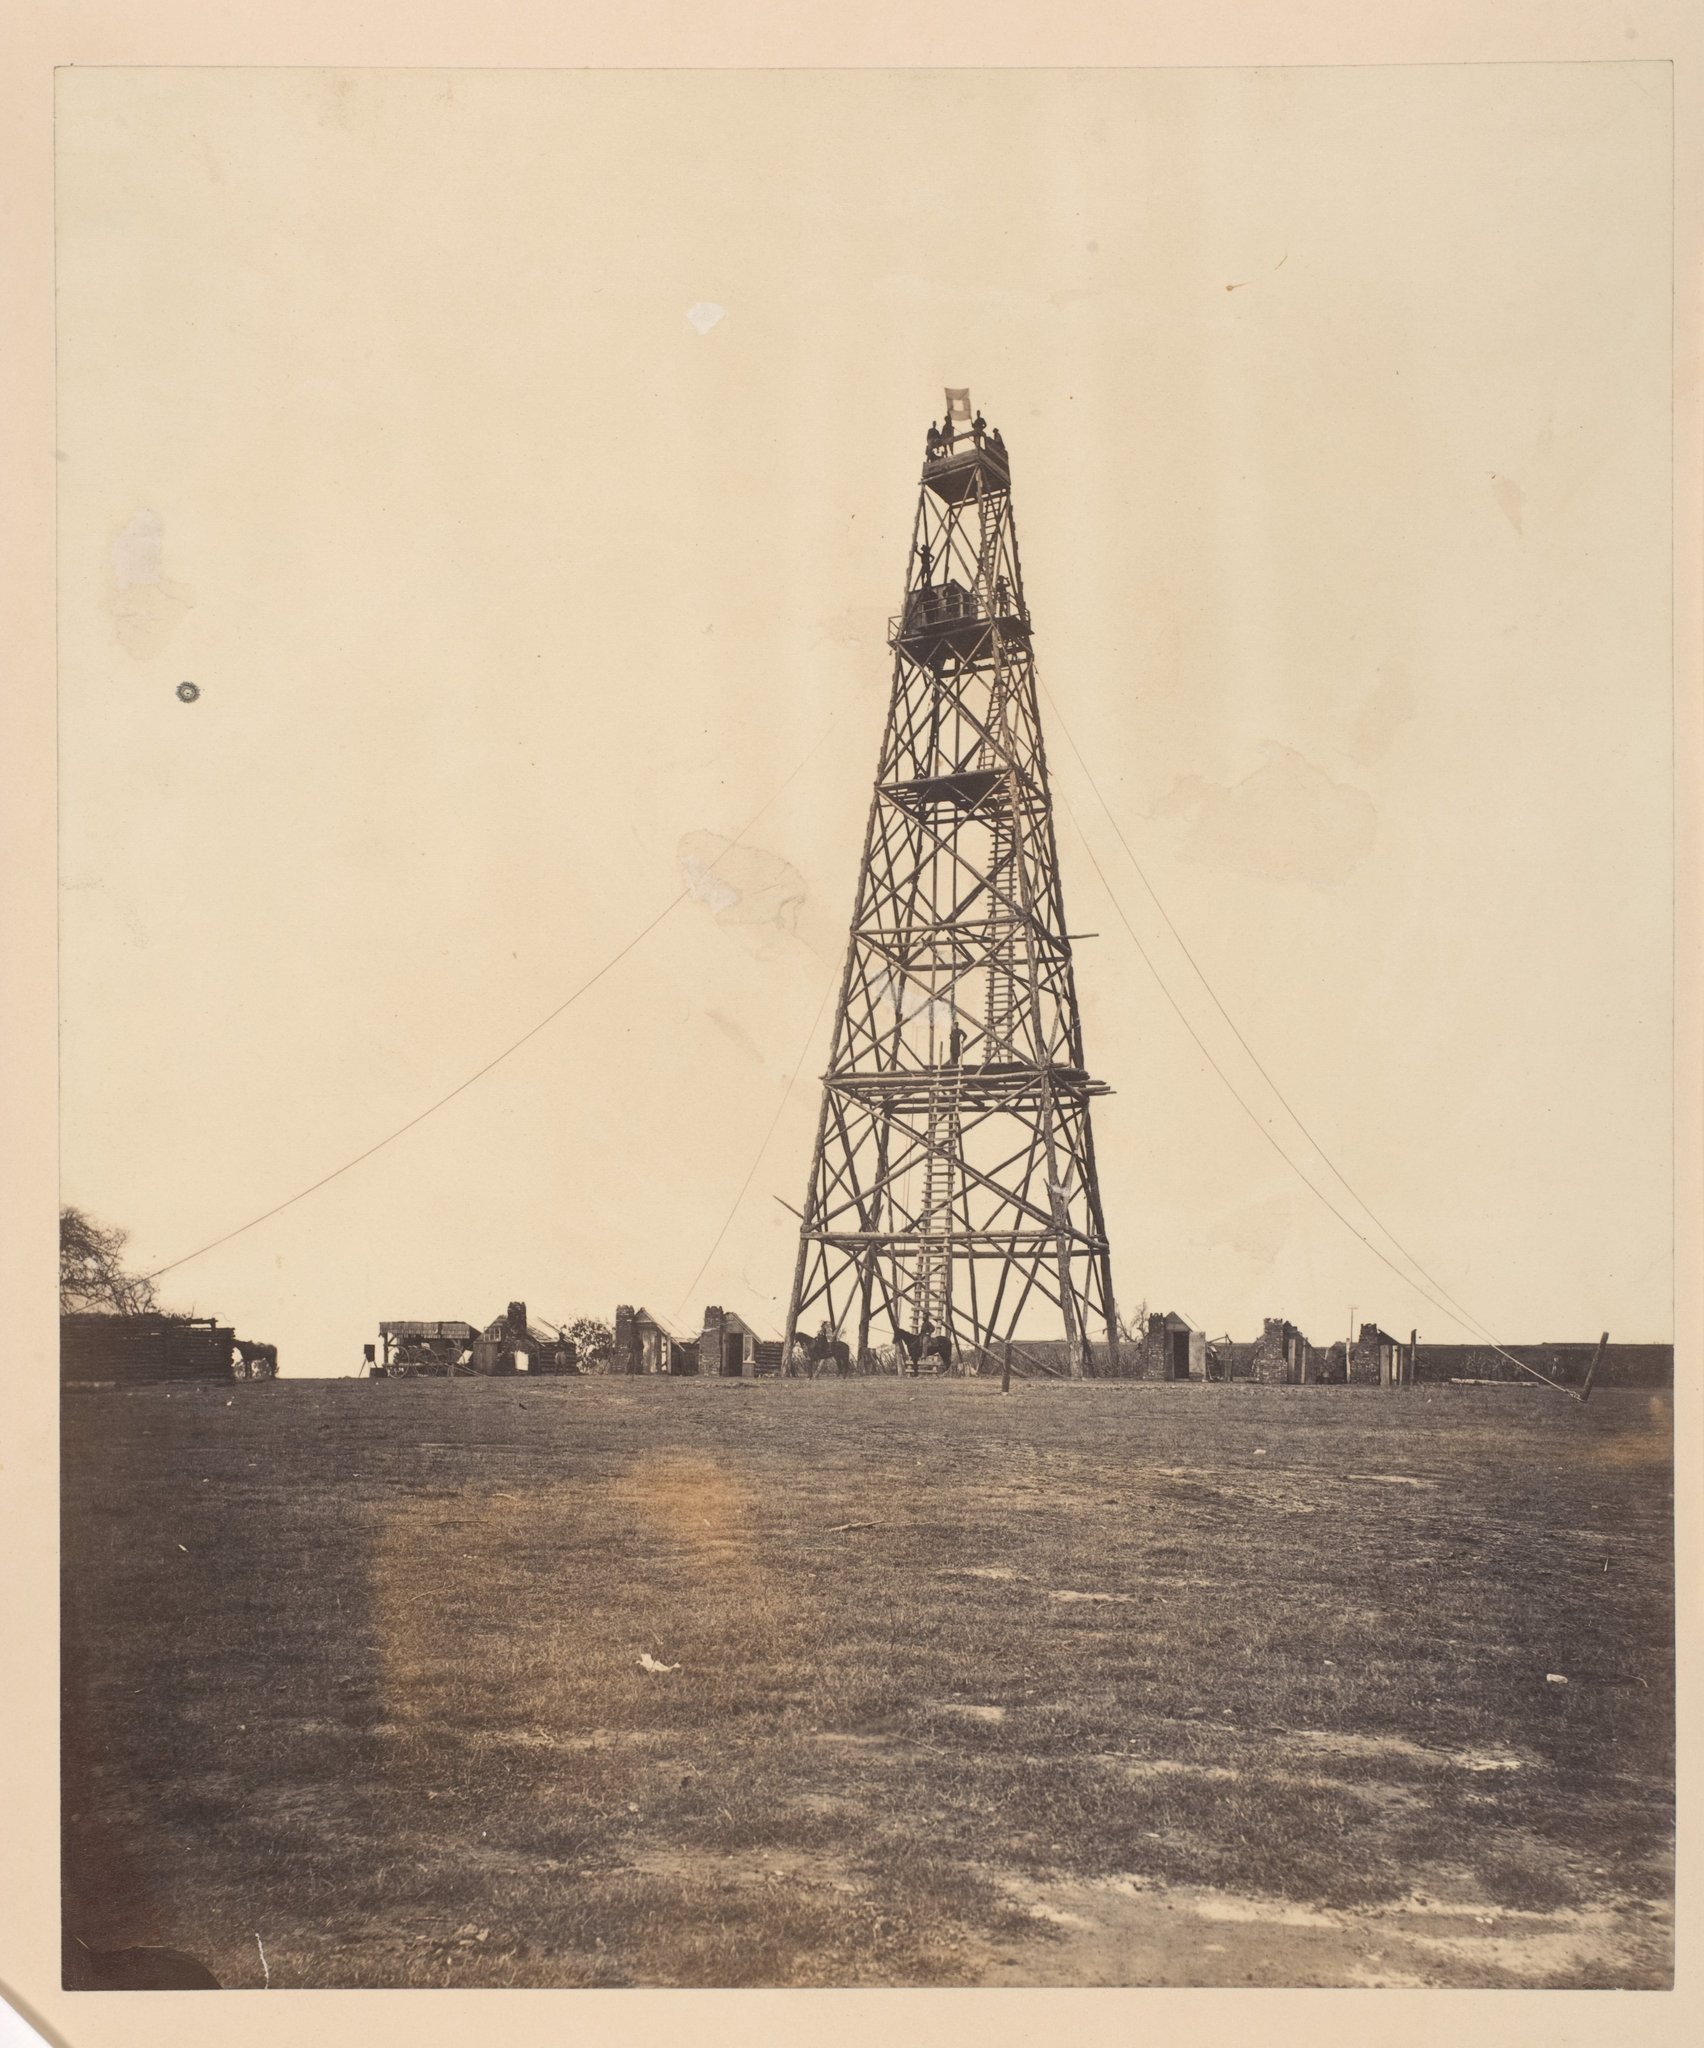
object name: photograph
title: [Civil War View]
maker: thomas c. roche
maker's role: artist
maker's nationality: american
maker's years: 1826-1895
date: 1860-1869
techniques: albumen silver print, glass negative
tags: towers,american civil war